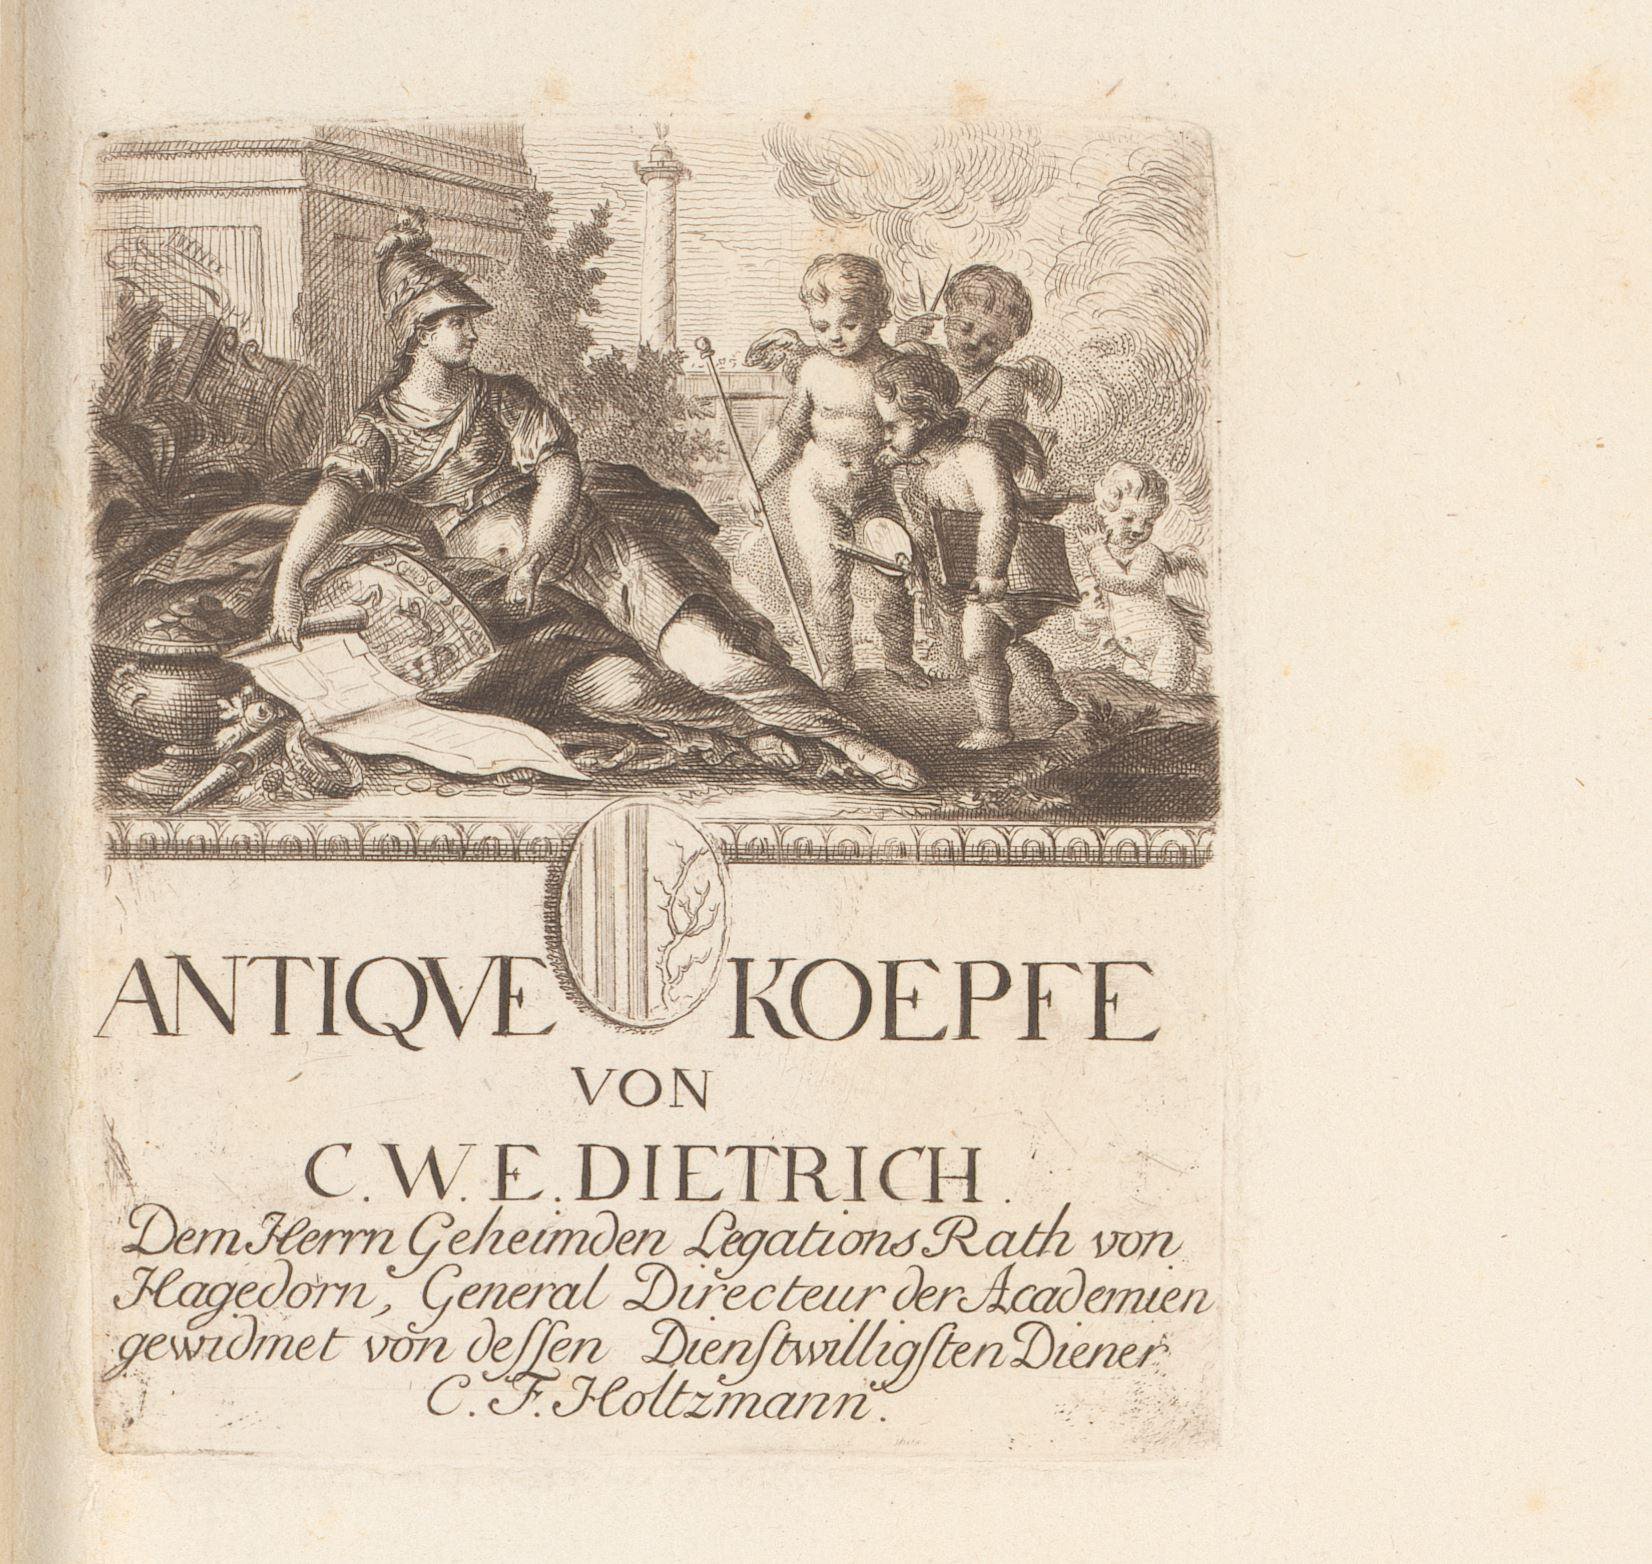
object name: print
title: Allegorie met Minerva en putti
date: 1764-1811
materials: paper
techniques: etching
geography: dresden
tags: minerva as patroness, cupids: 'amores', 'amoretti', 'putti'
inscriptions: collector's mark: Lugt 2228, collector's mark: Lugt 2760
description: Tekst in het Duits in de ondermarge, mogelijk de titelprent voor een serie van antieke koppen en hoofden. Prent maakt deel uit van een album.